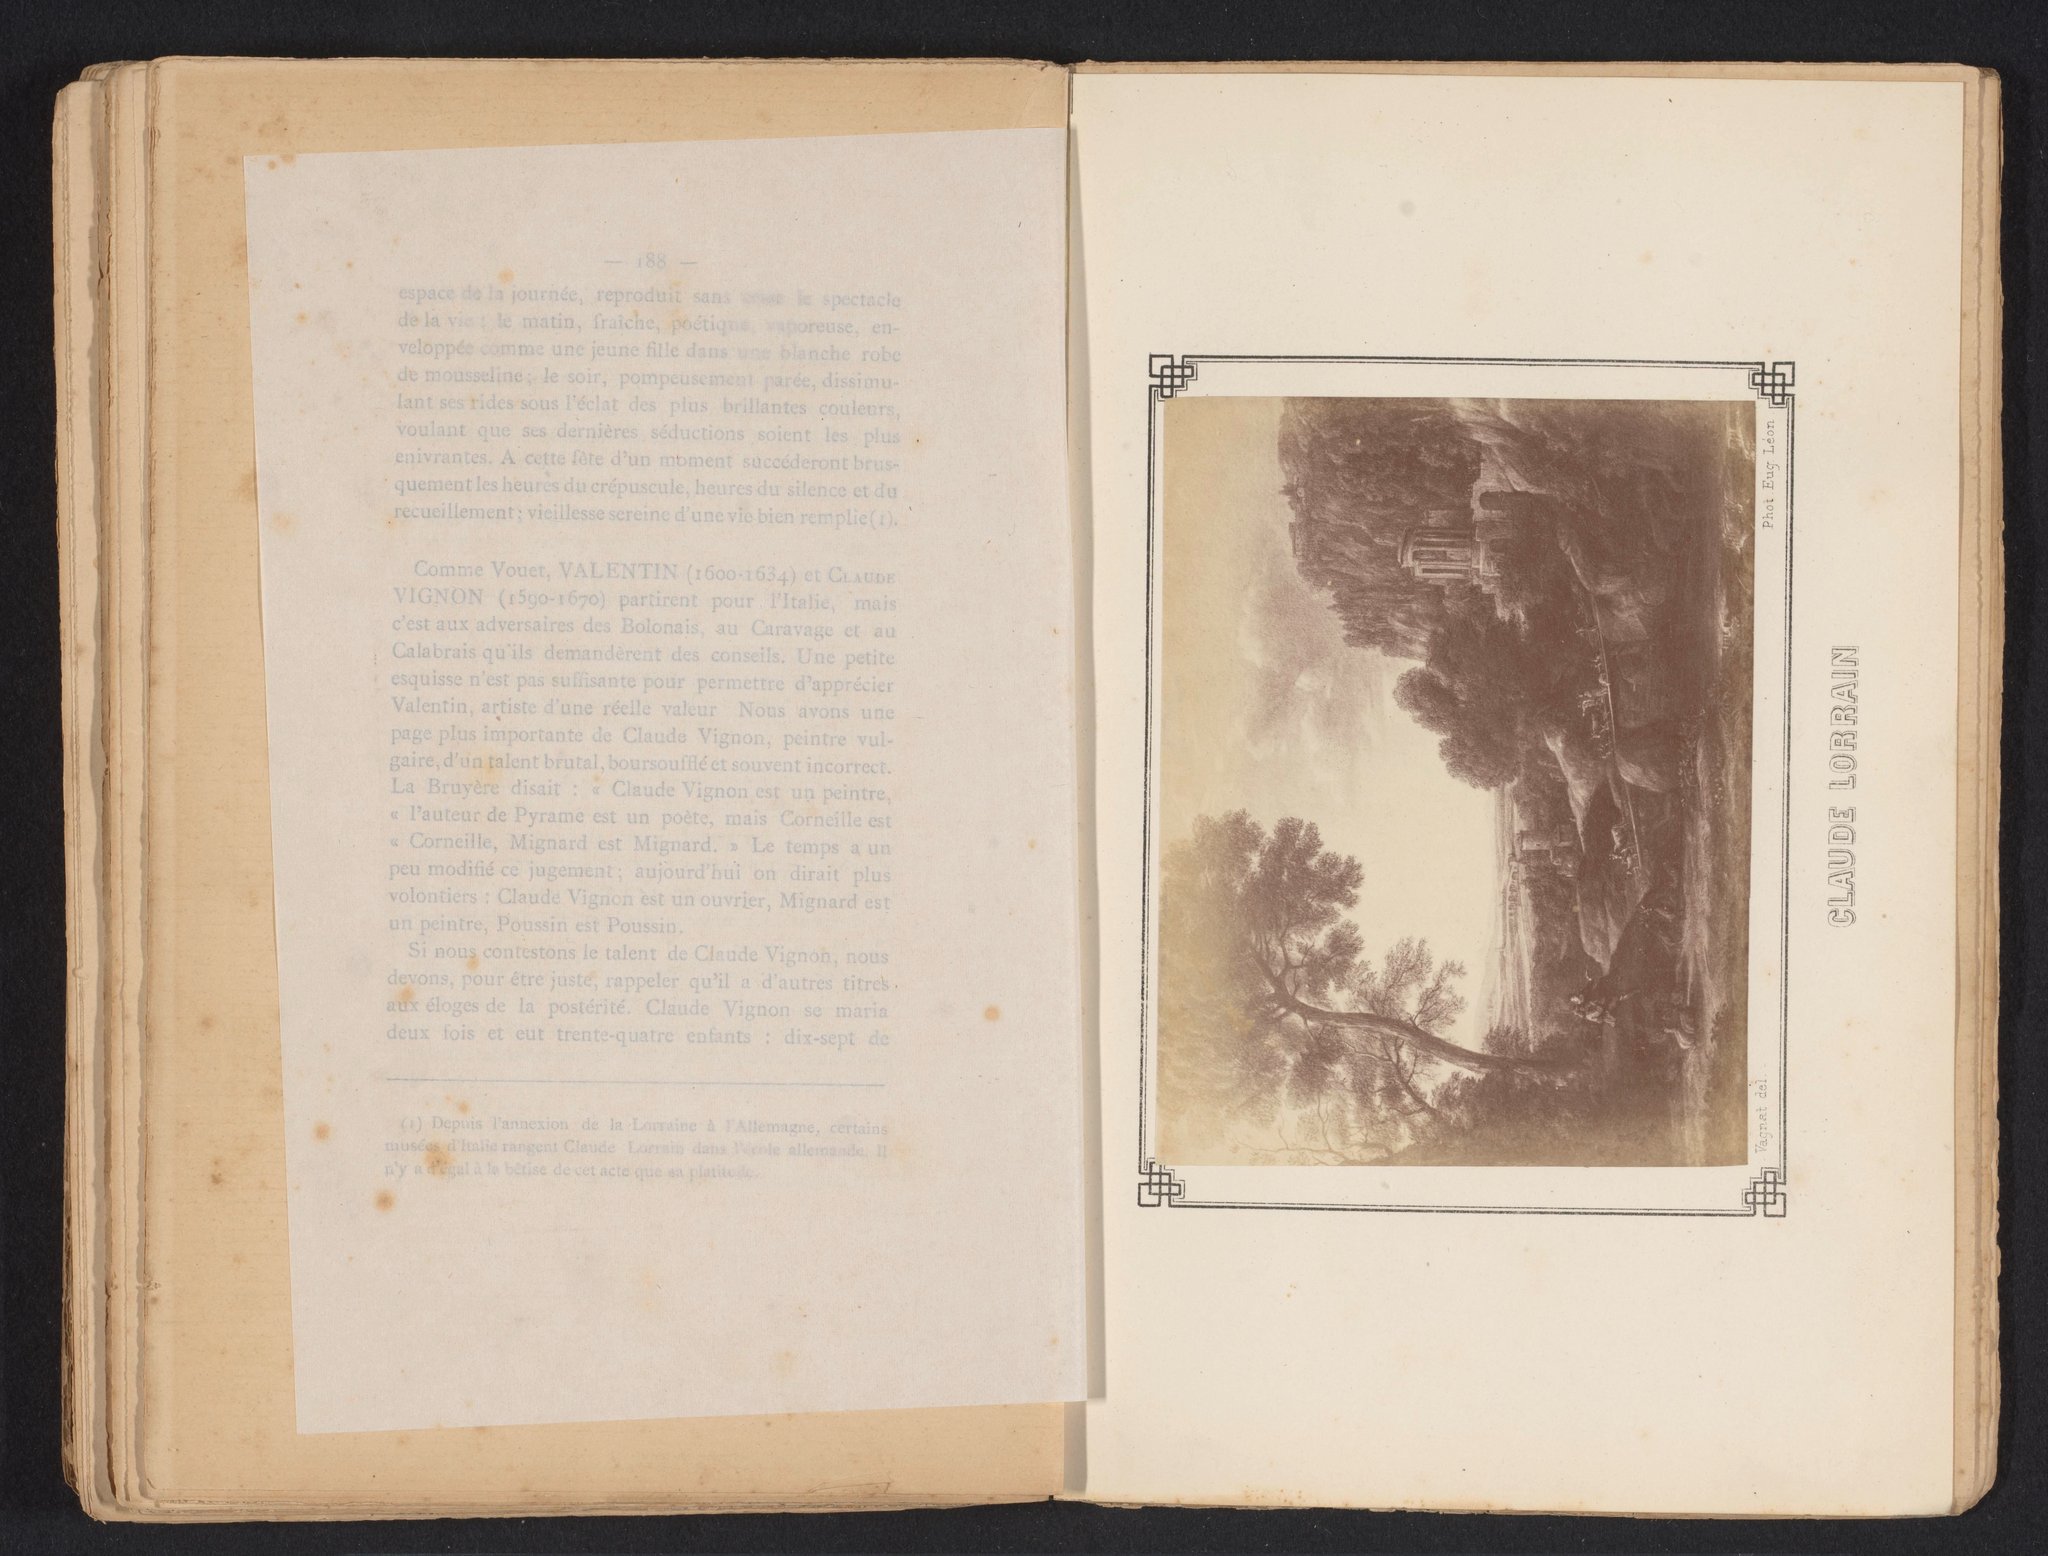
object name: reproduction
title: Claude Lorrain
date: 1869-1879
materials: photographic support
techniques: albumen print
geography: grenoble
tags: symbolic representations, allegories and emblems ~ pastoral poetry; 'poema pastorale' (ripa), picture, painting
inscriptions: inscription: ‘Vagnat del.’